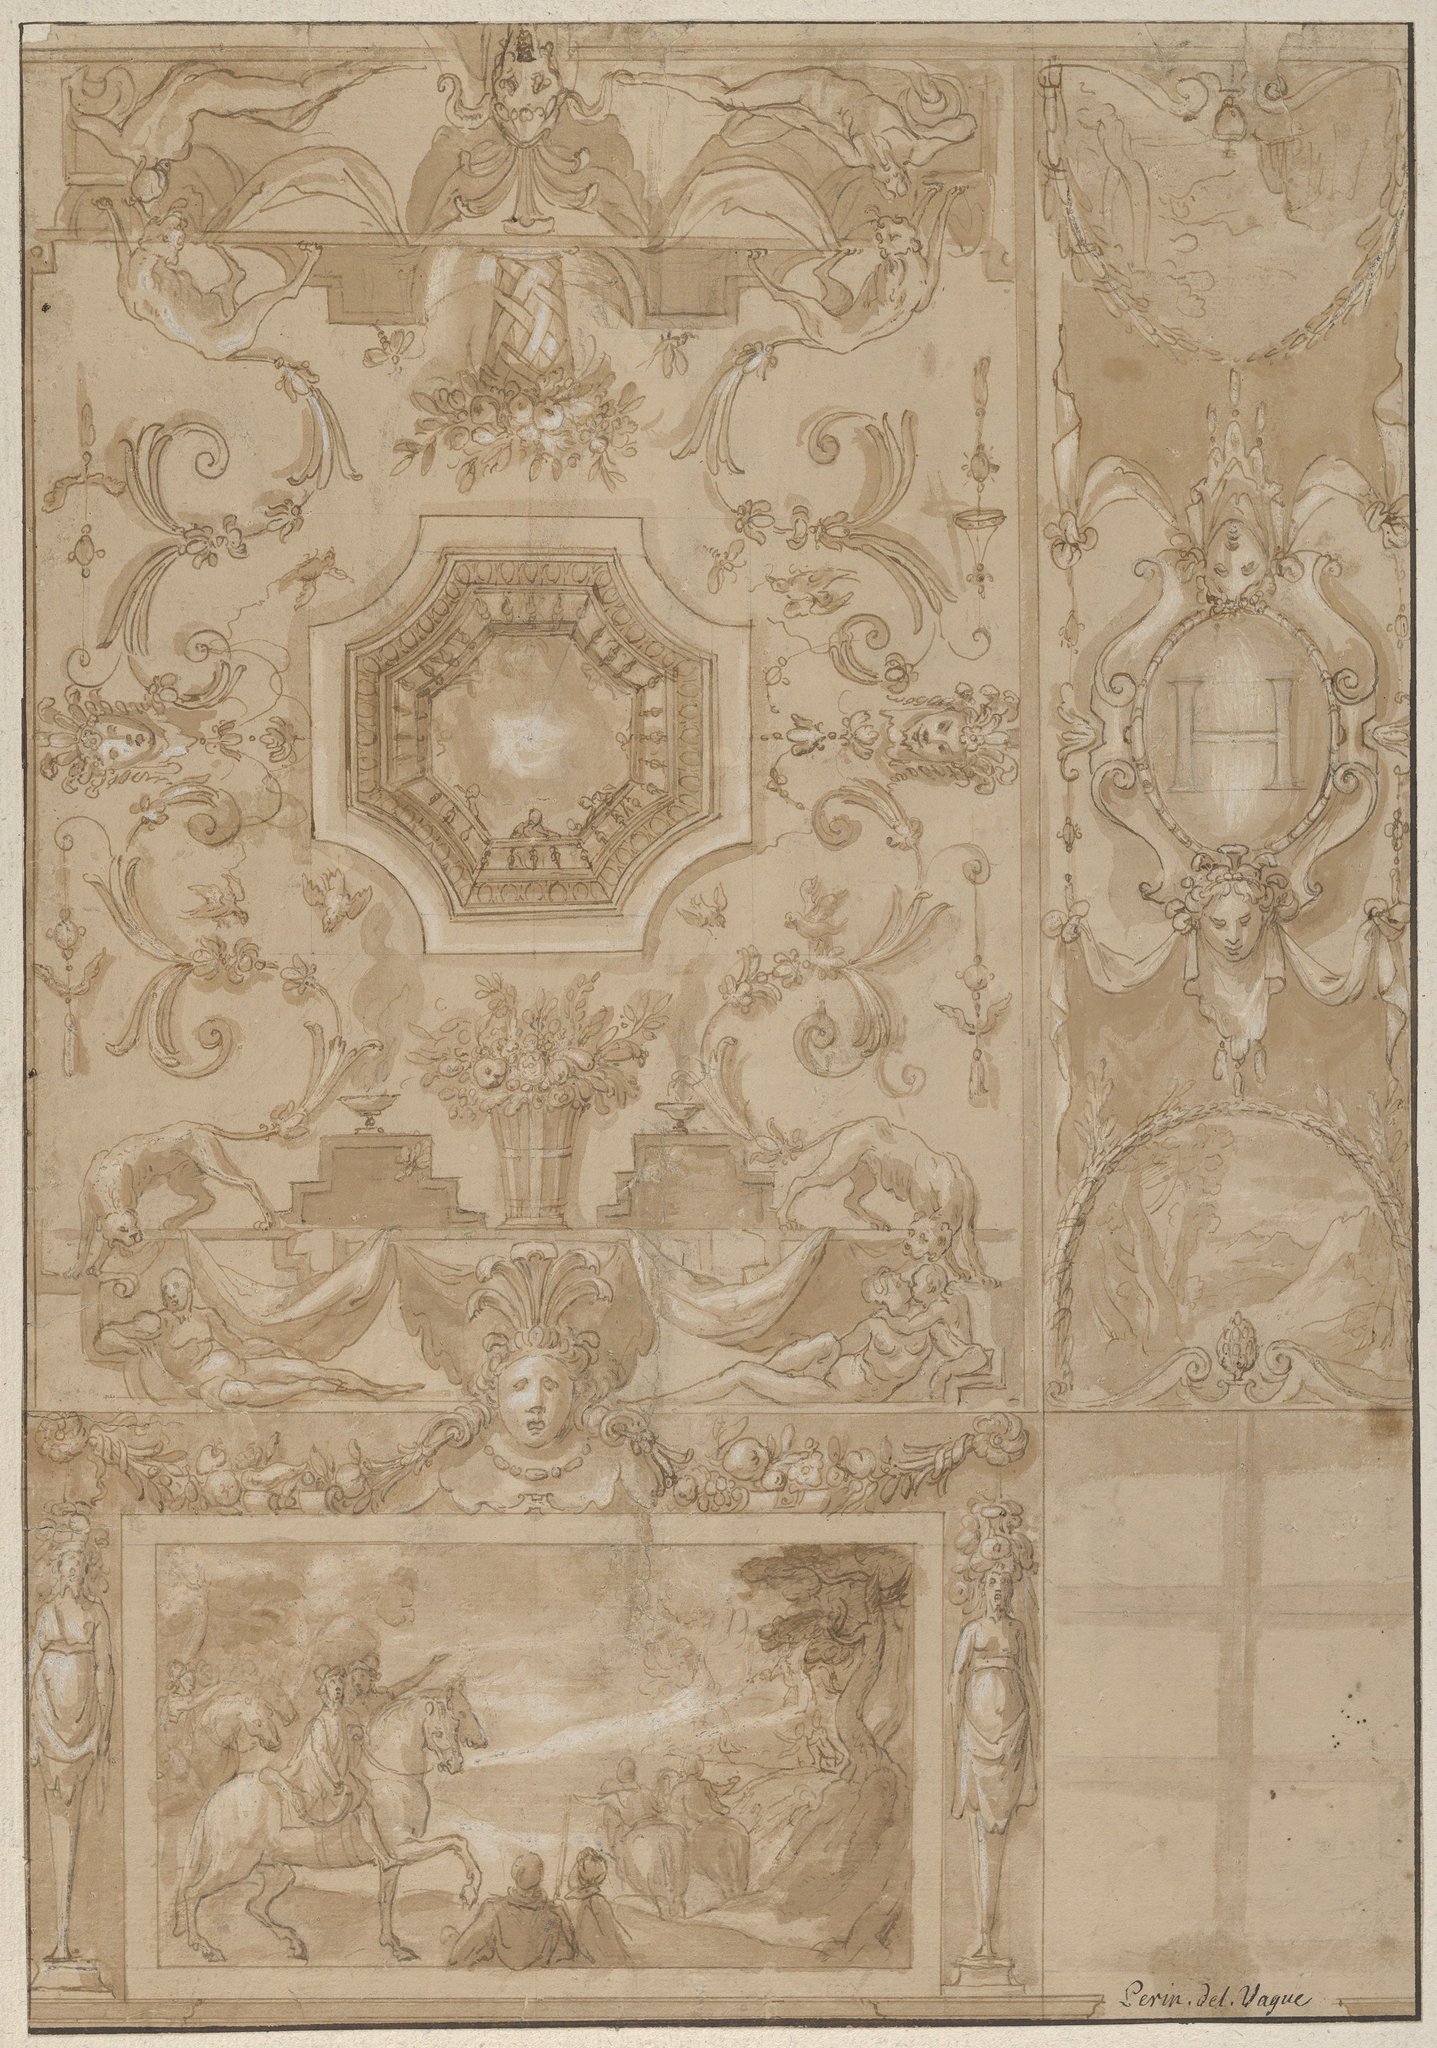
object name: drawing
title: Design for a Decorated Wall and Ceiling of a Gallery, marked with the monogram of the French King Henri III or IV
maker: toussaint dubreuil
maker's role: artist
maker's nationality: french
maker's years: 1561-1602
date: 1580-1600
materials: chalk, ink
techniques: brush, heightening, pen, wash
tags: animals,faces,men,female nudes,horses